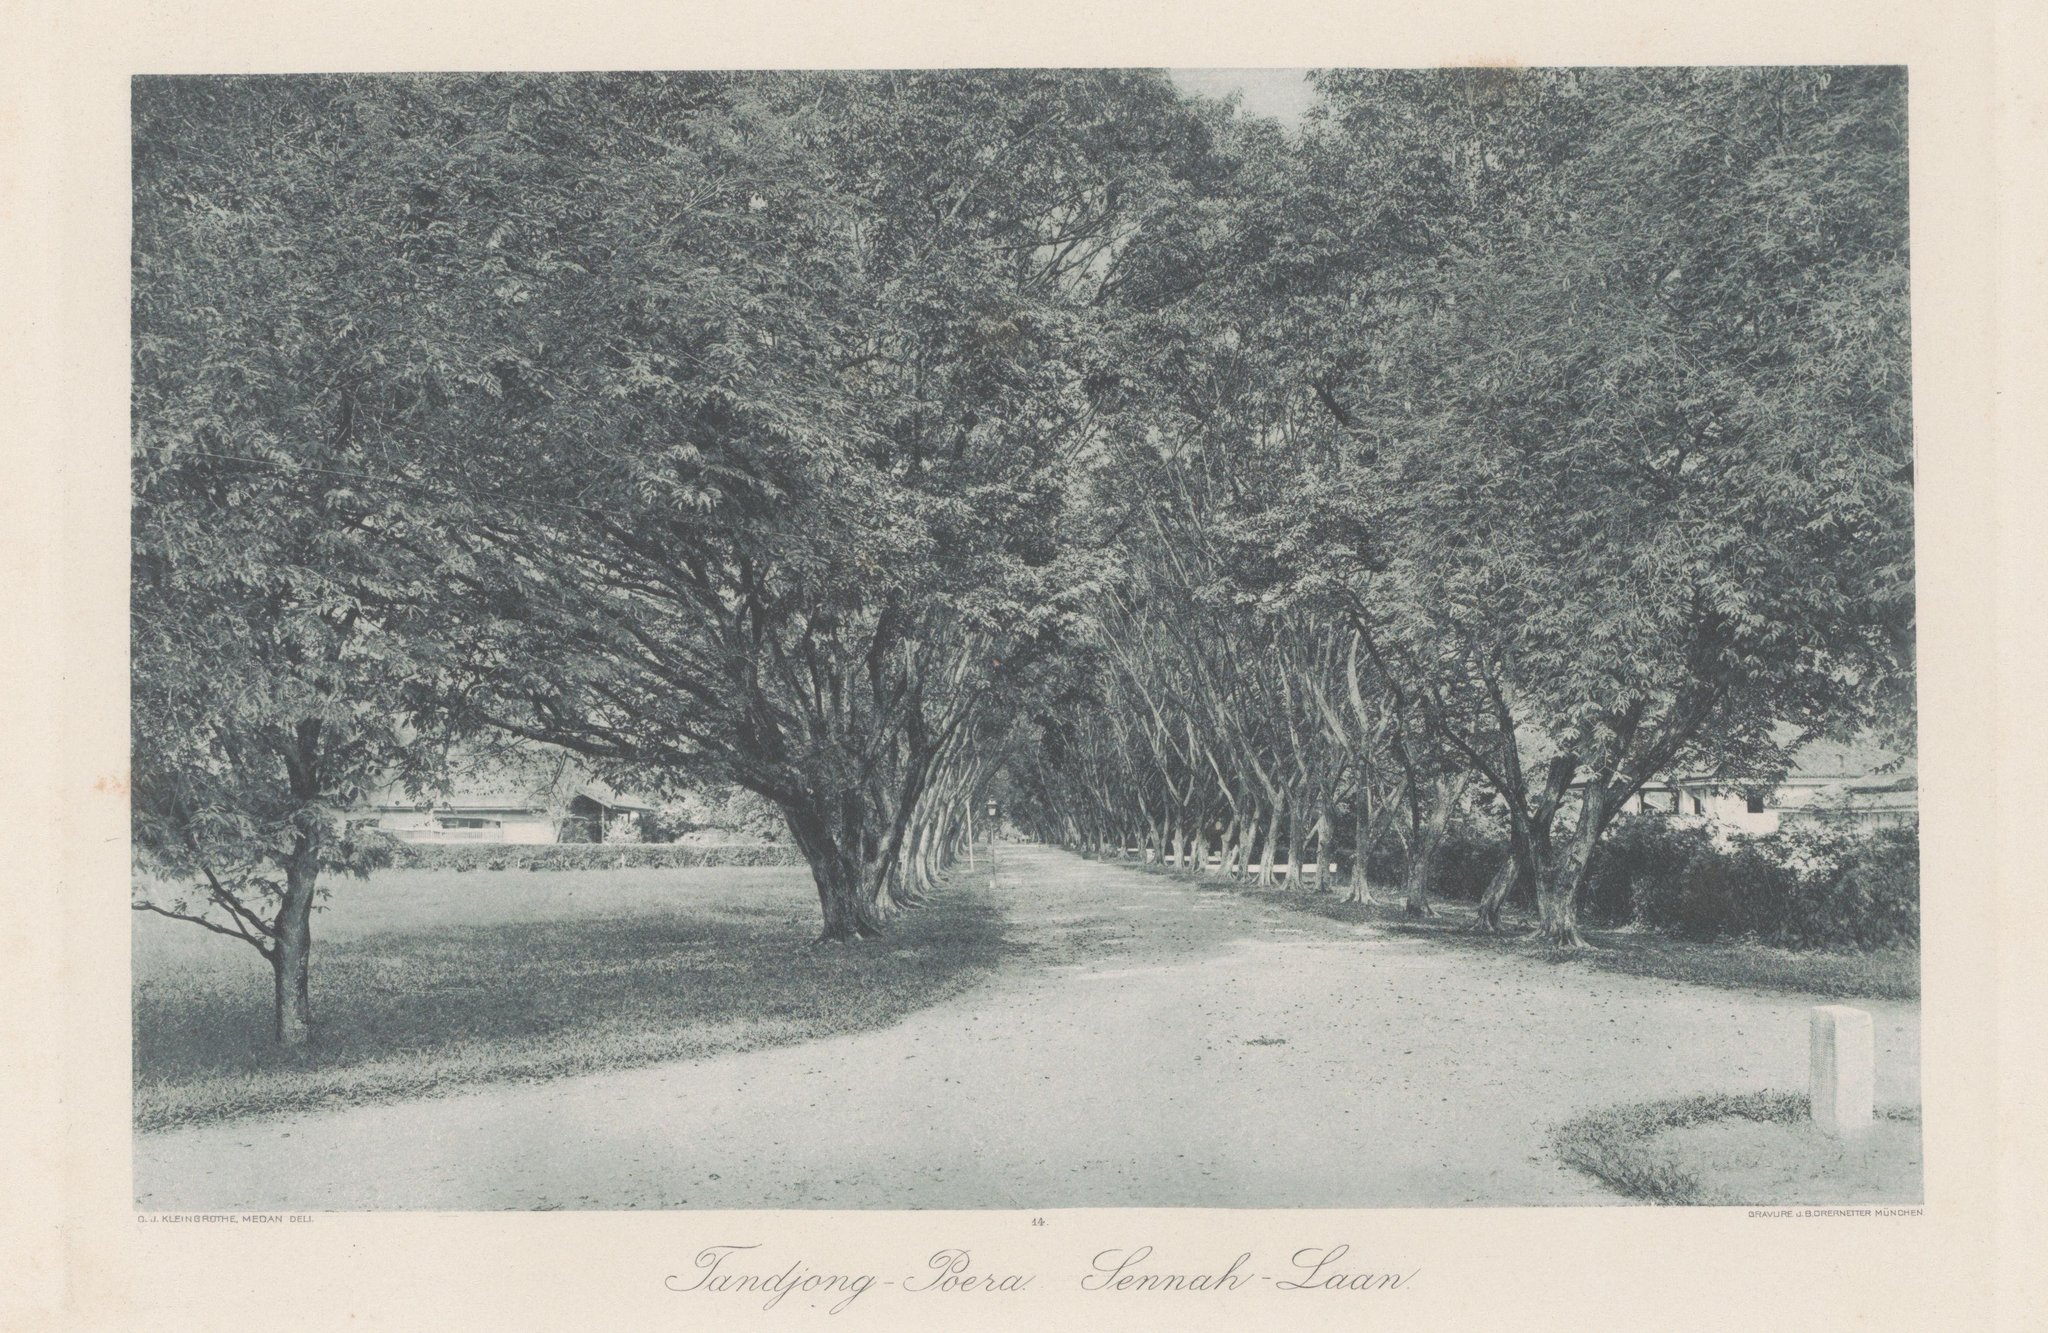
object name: photomechanical print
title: Tandjong-Poera Sennah-laan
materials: paper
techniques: photoaquatint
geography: tanjungpura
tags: forest path or lane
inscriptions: number: ‘14’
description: Onderdeel van Album met heliogravures van Sumatra's oostkust.